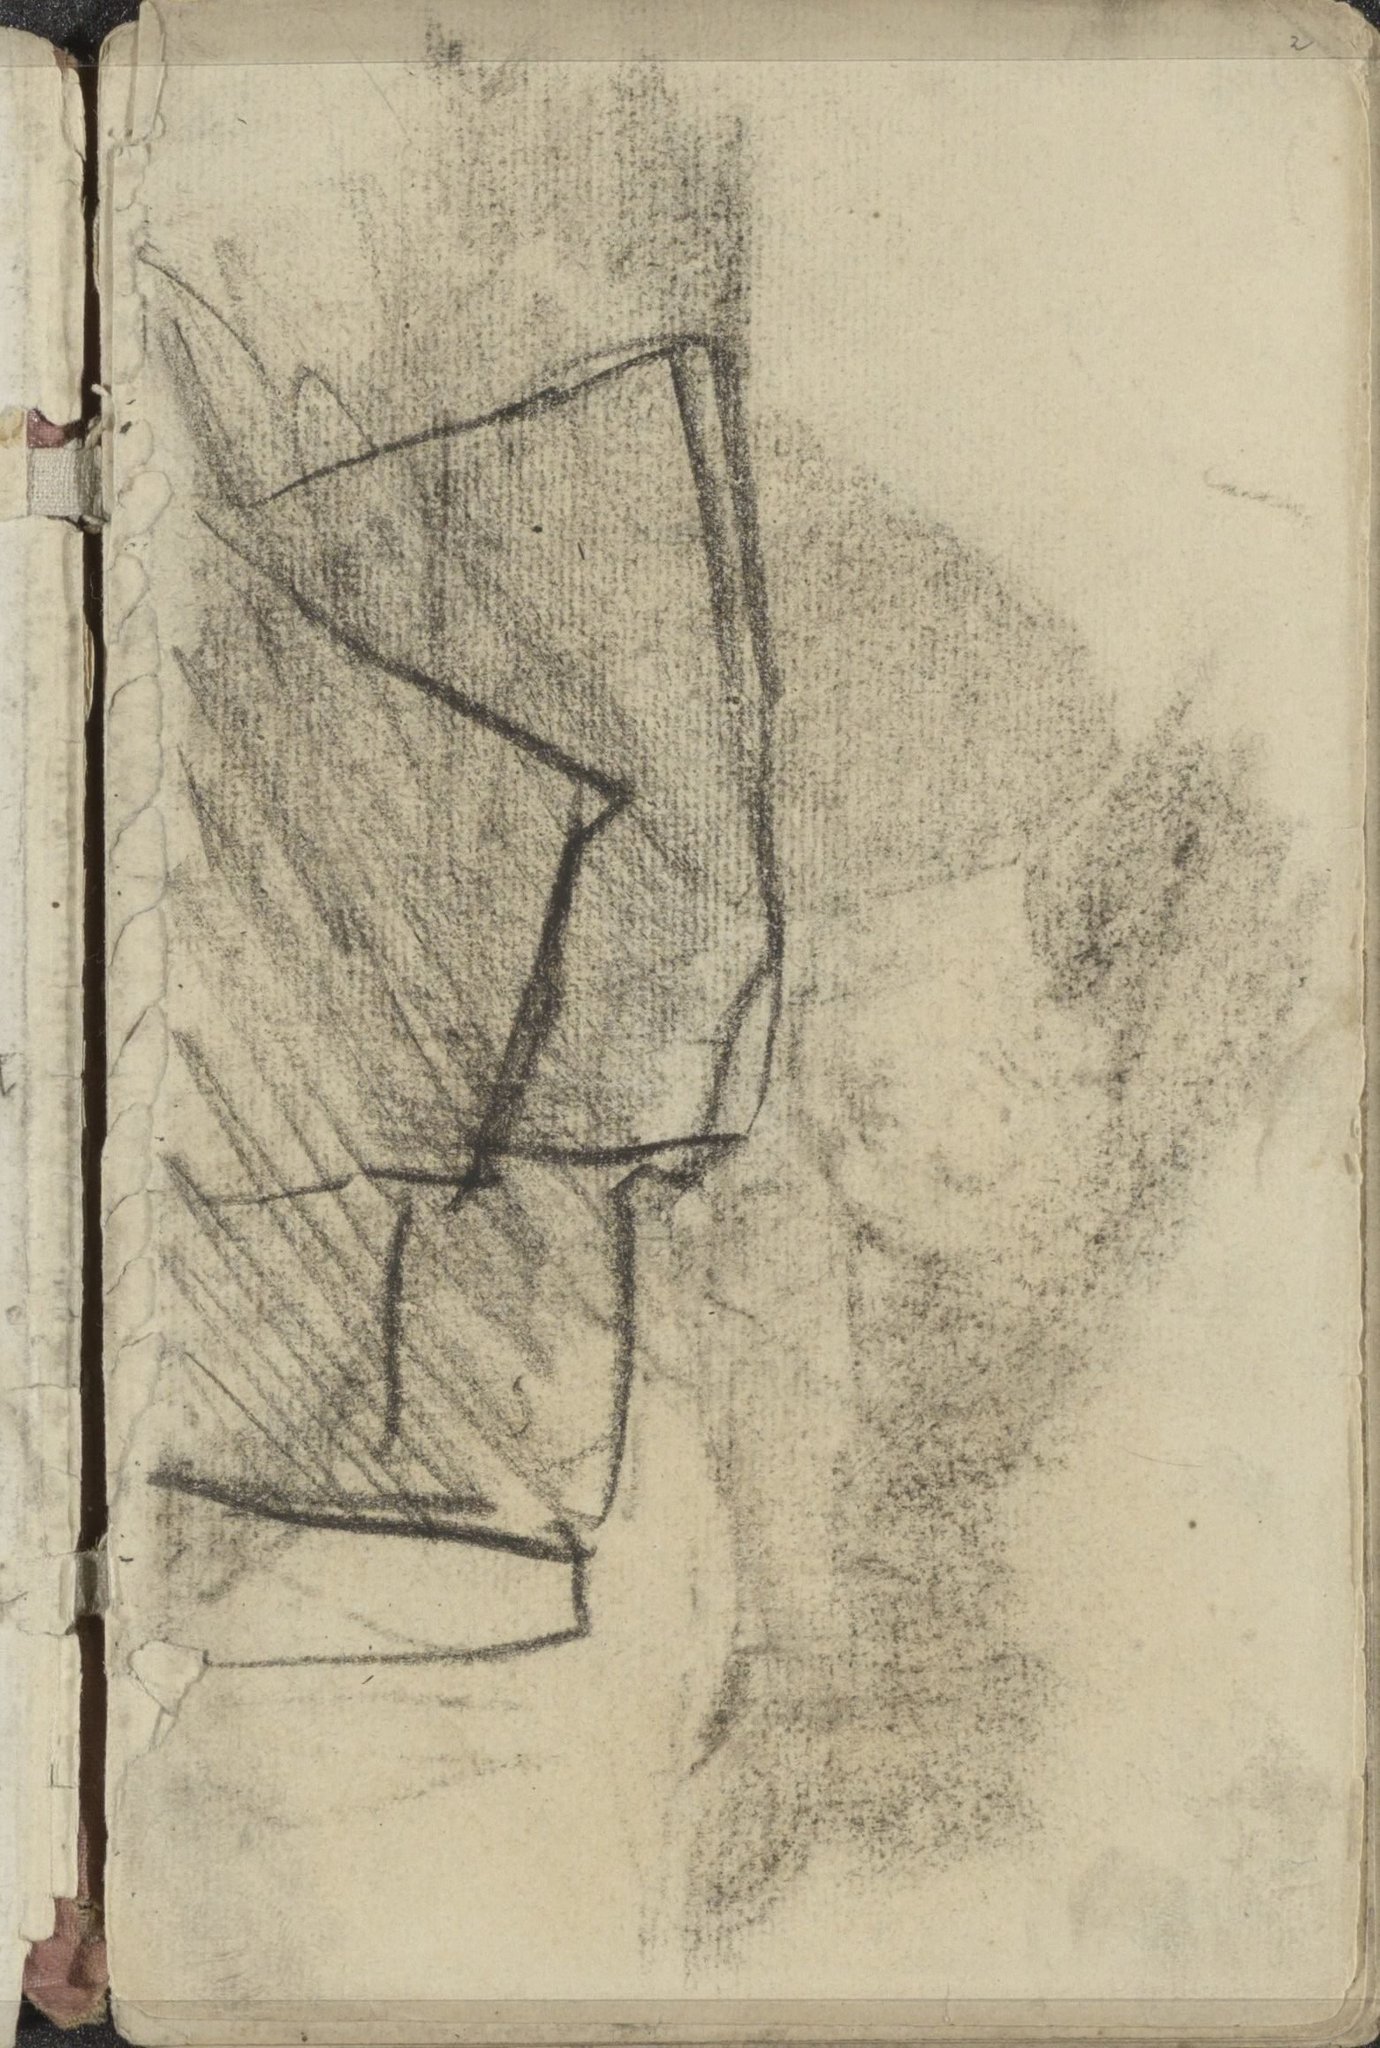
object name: sketchbook leaf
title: Studie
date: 1883-1885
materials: chalk, paper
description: Pagina 2 uit een schetsboek met 16 bladen.